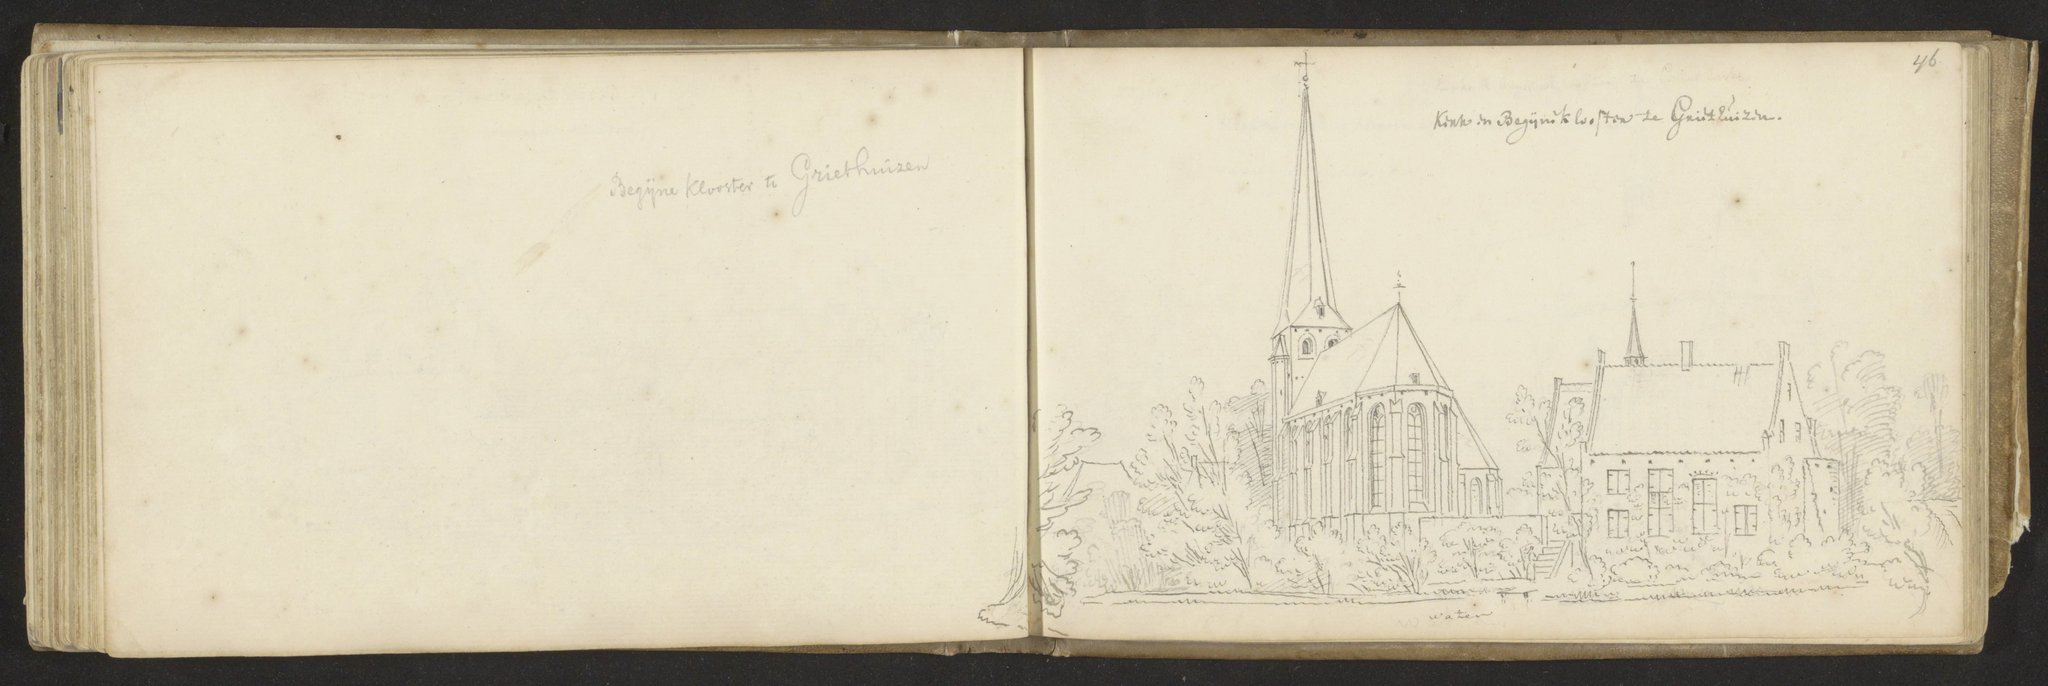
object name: sketchbook leaf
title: Kerk en Begijnenklooster te Griethausen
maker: abraham de haen (ii)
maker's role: draughtsman, print maker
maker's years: 1707-1748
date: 1731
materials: ink, paper, pencil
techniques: pen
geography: griethausen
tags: abbey, monastery, convent ~ roman catholic church, church (exterior)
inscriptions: annotation: ‘Kerk en Begijnenklooster te Griethuizen/ water’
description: Blad 45 verso en 46 recto uit een schetsboek met 69 bladen.